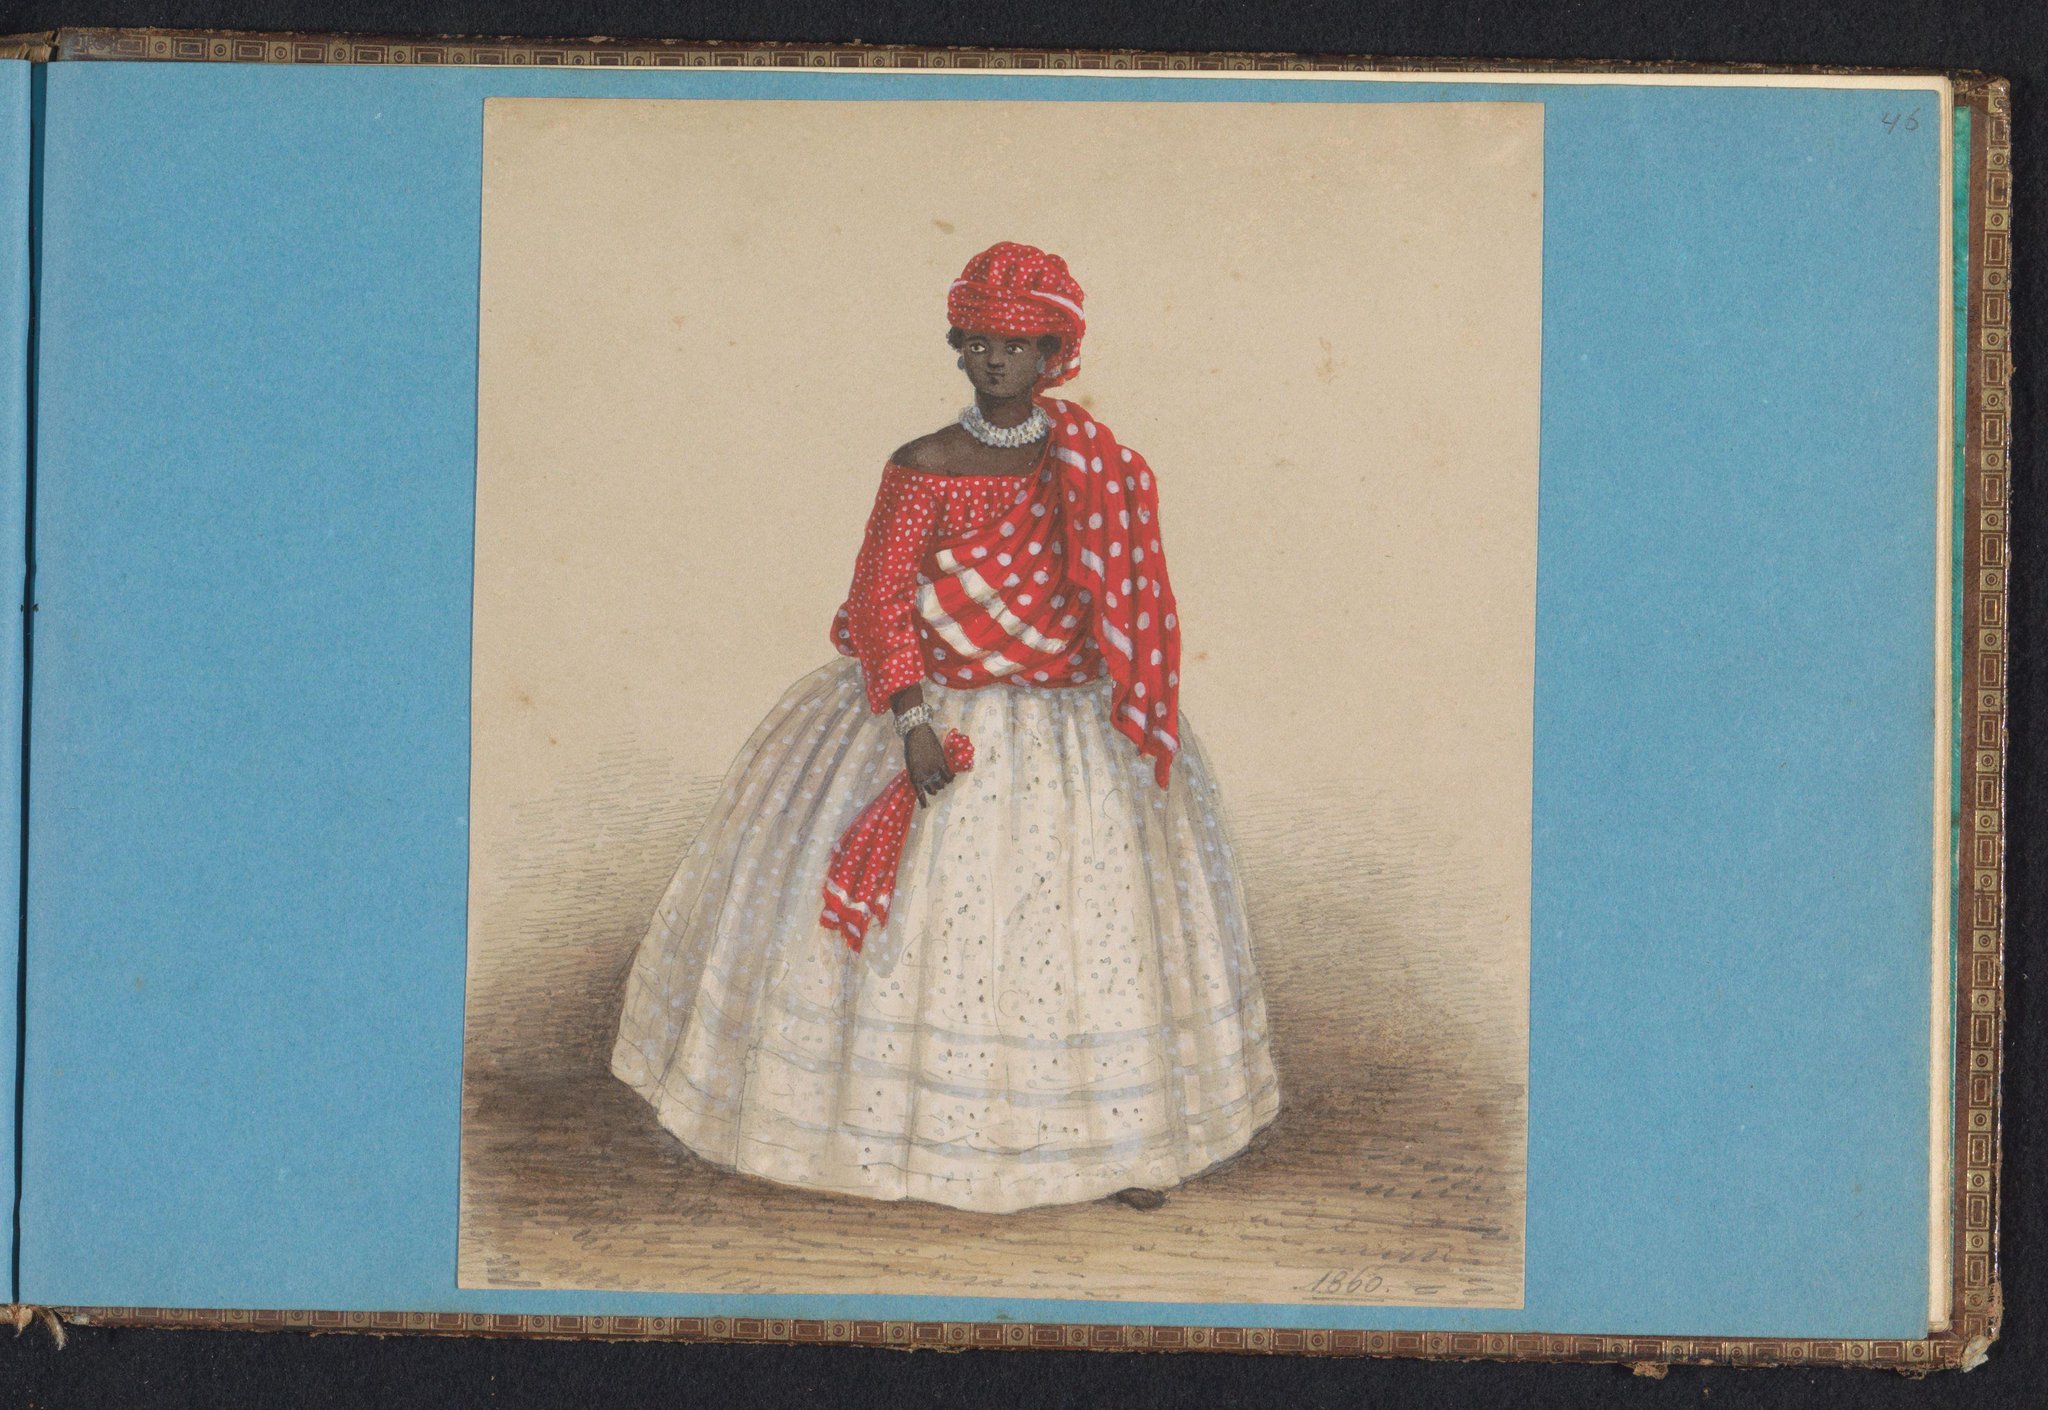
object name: watercolor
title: Vrouw in koto misi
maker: jacob marius adriaan martini van geffen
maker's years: 1821-1866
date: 1860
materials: ink, paper, pencil, watercolor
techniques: brush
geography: suriname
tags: suriname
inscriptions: signature and date: ‘recto r.o. gedateerd: 1860’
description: De vrouw draagt een witte rok, een jak, angisa en zakdoek van een rode stof met witte stippen. De omslagdoek heeft een vergelijkbaar motief maar dan groter.